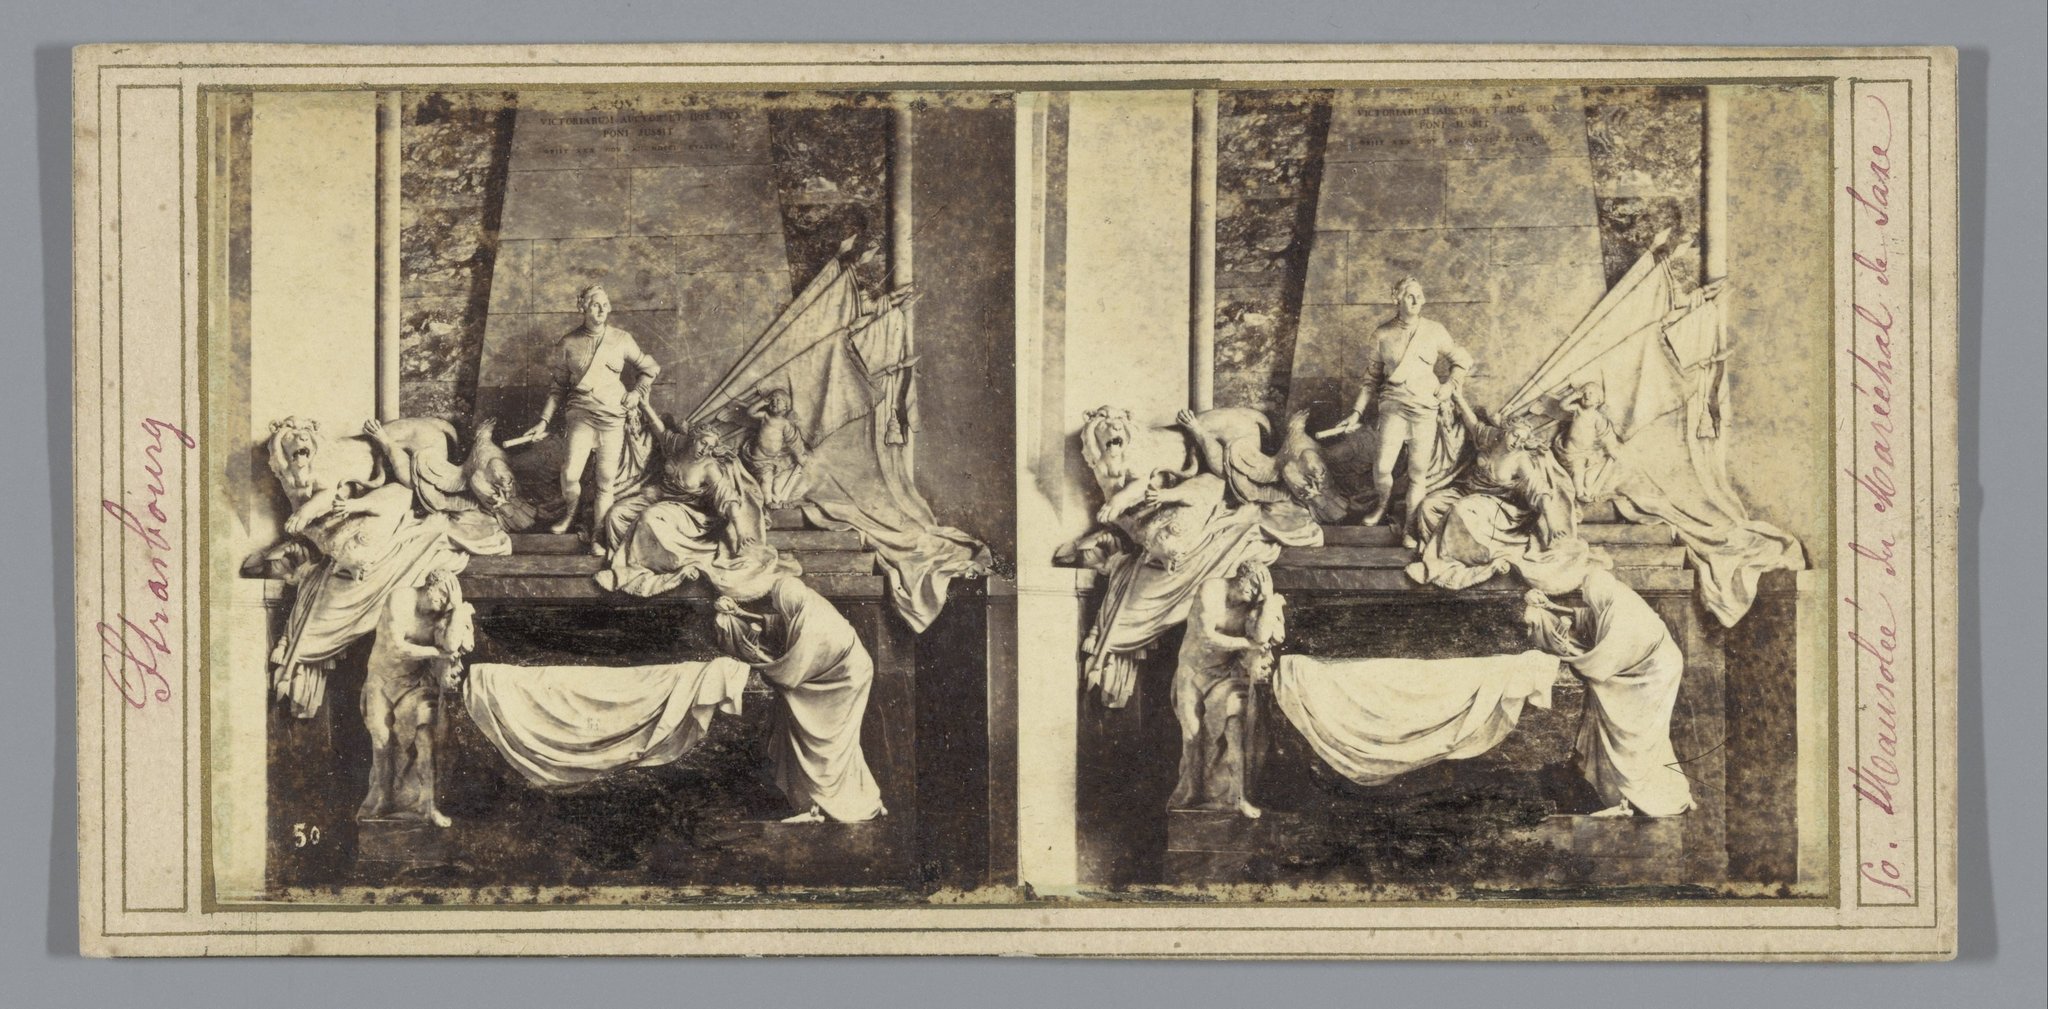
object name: stereograph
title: Praalgraf van Maurits van Saksen in de Sint Thomaskerk in Straatsburg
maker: Anonymous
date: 1850-1880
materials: cardboard, photographic support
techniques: albumen print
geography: straatsburg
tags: mausoleum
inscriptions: number: ‘10.’, inscription: ‘Strasbourg’